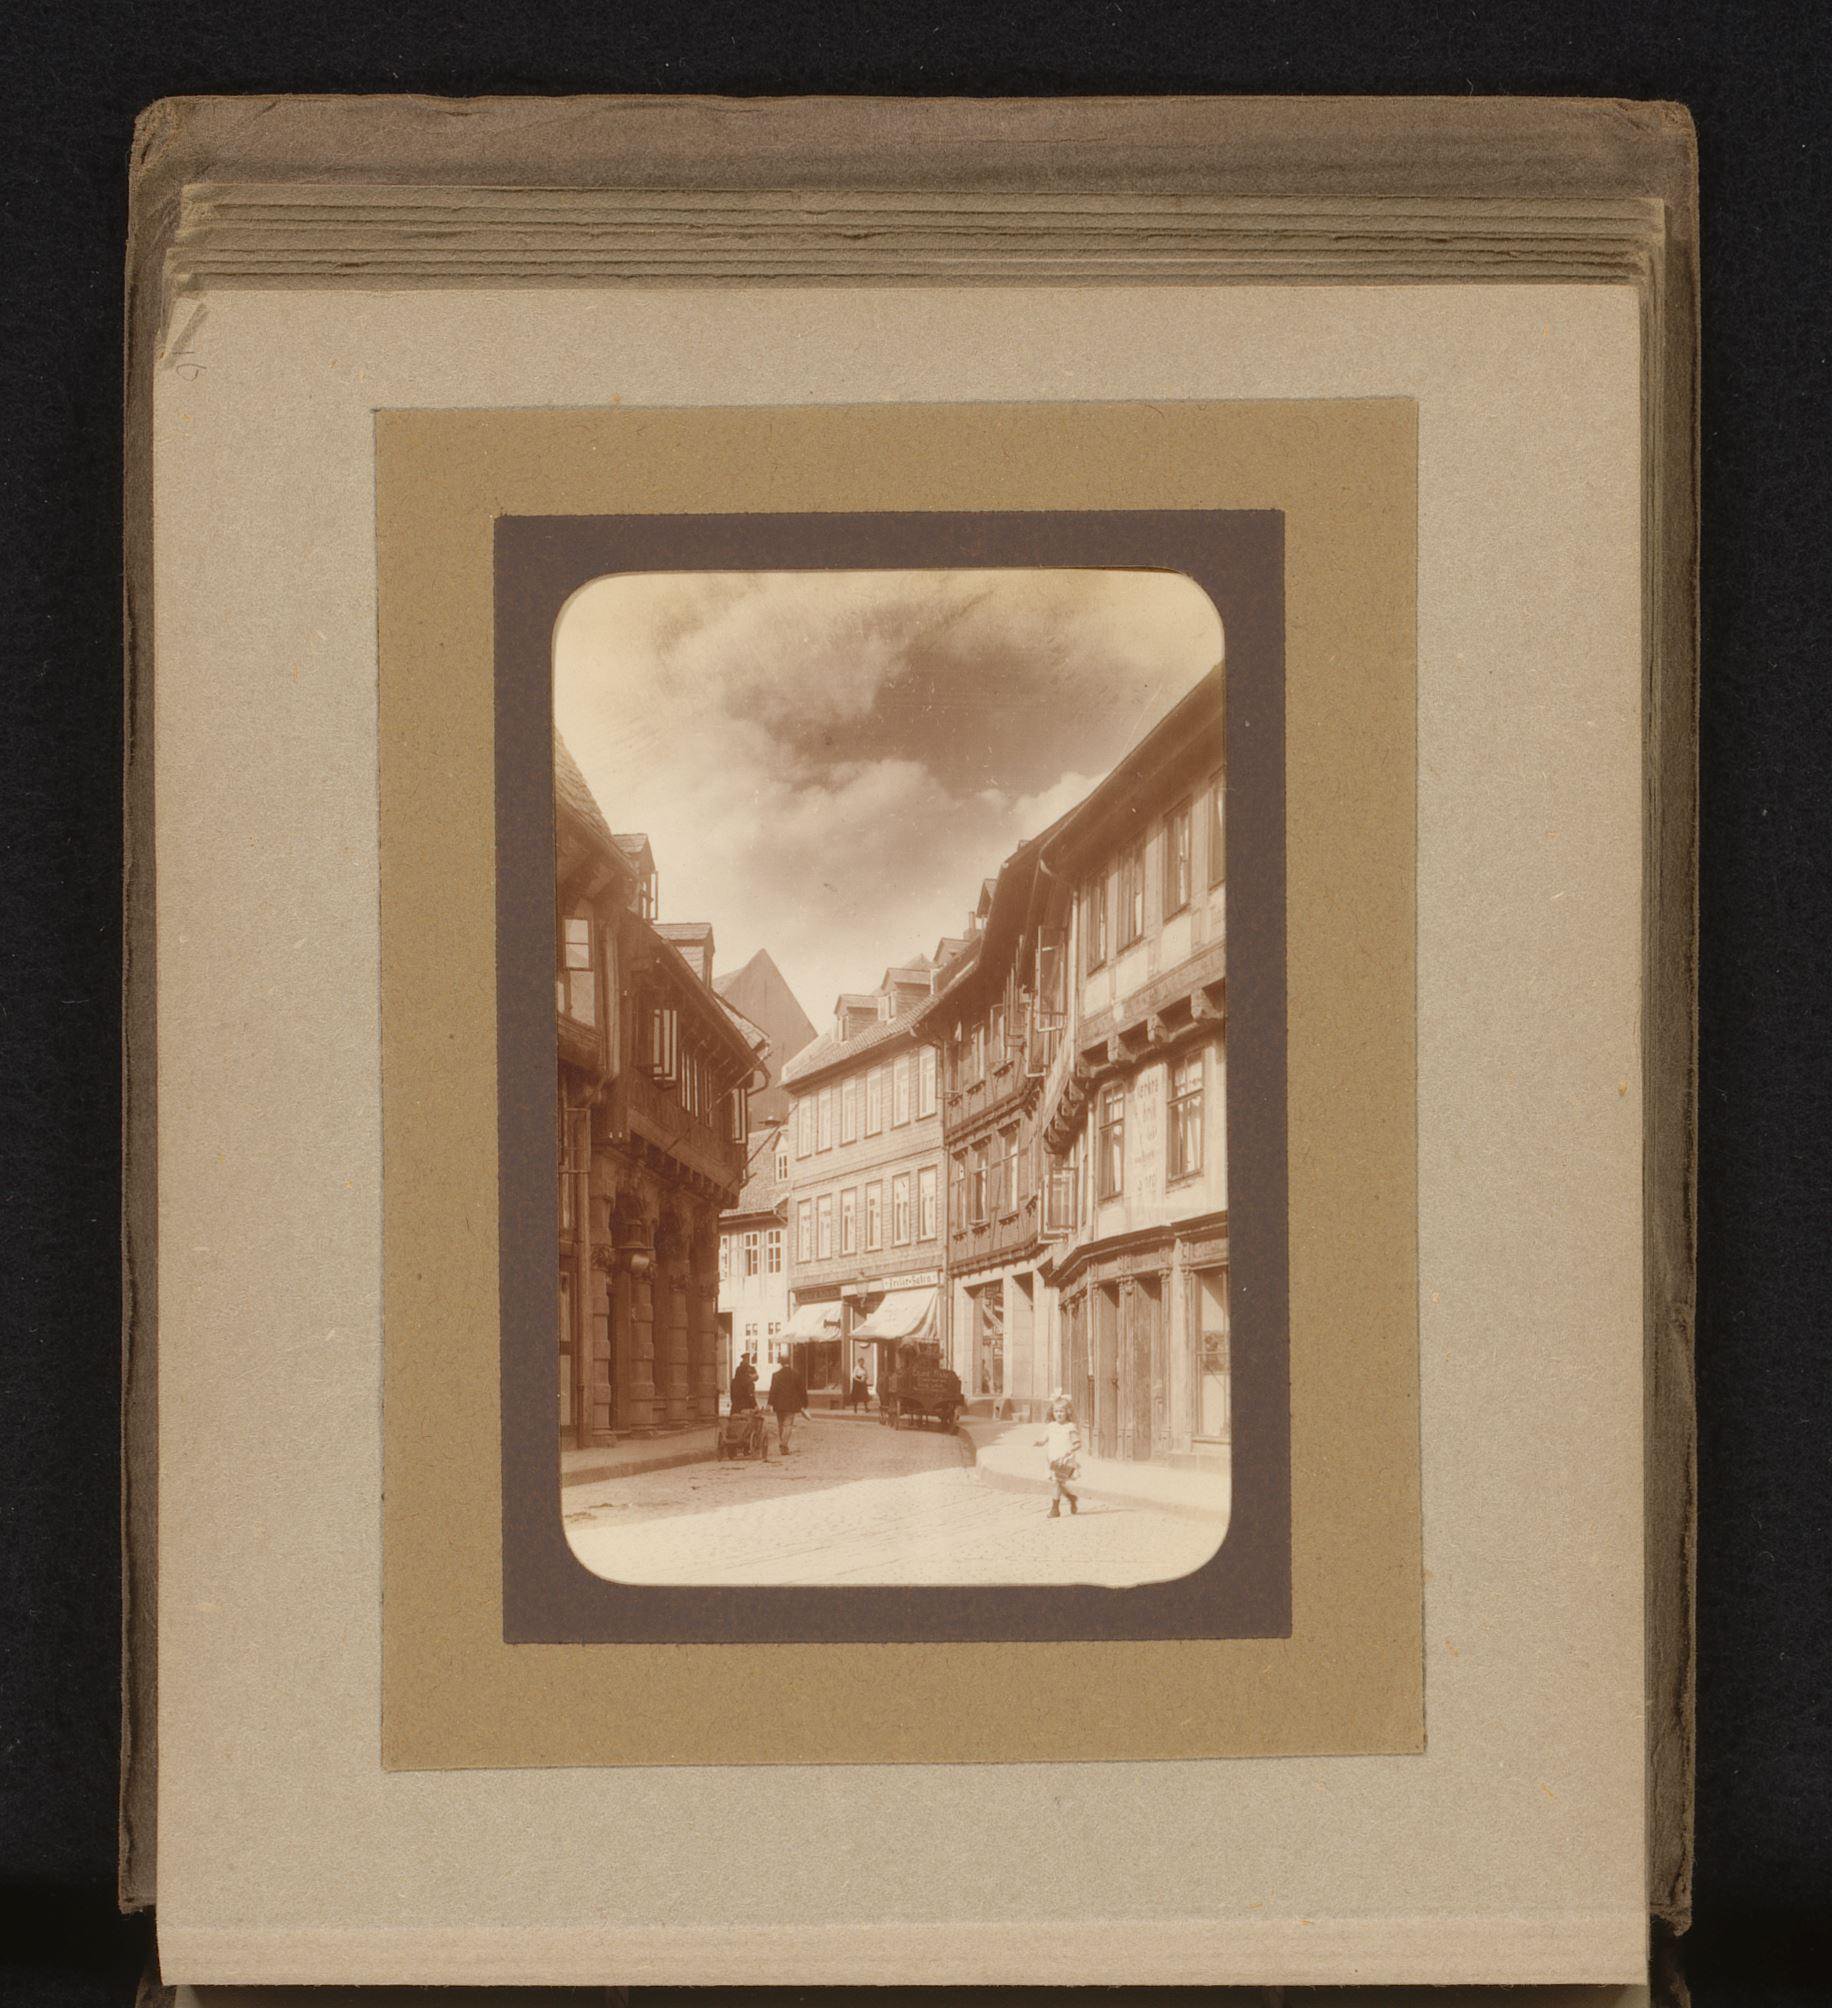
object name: photograph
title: Straatgezicht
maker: Anonymous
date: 1900-1930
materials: photographic support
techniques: gelatin silver print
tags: street